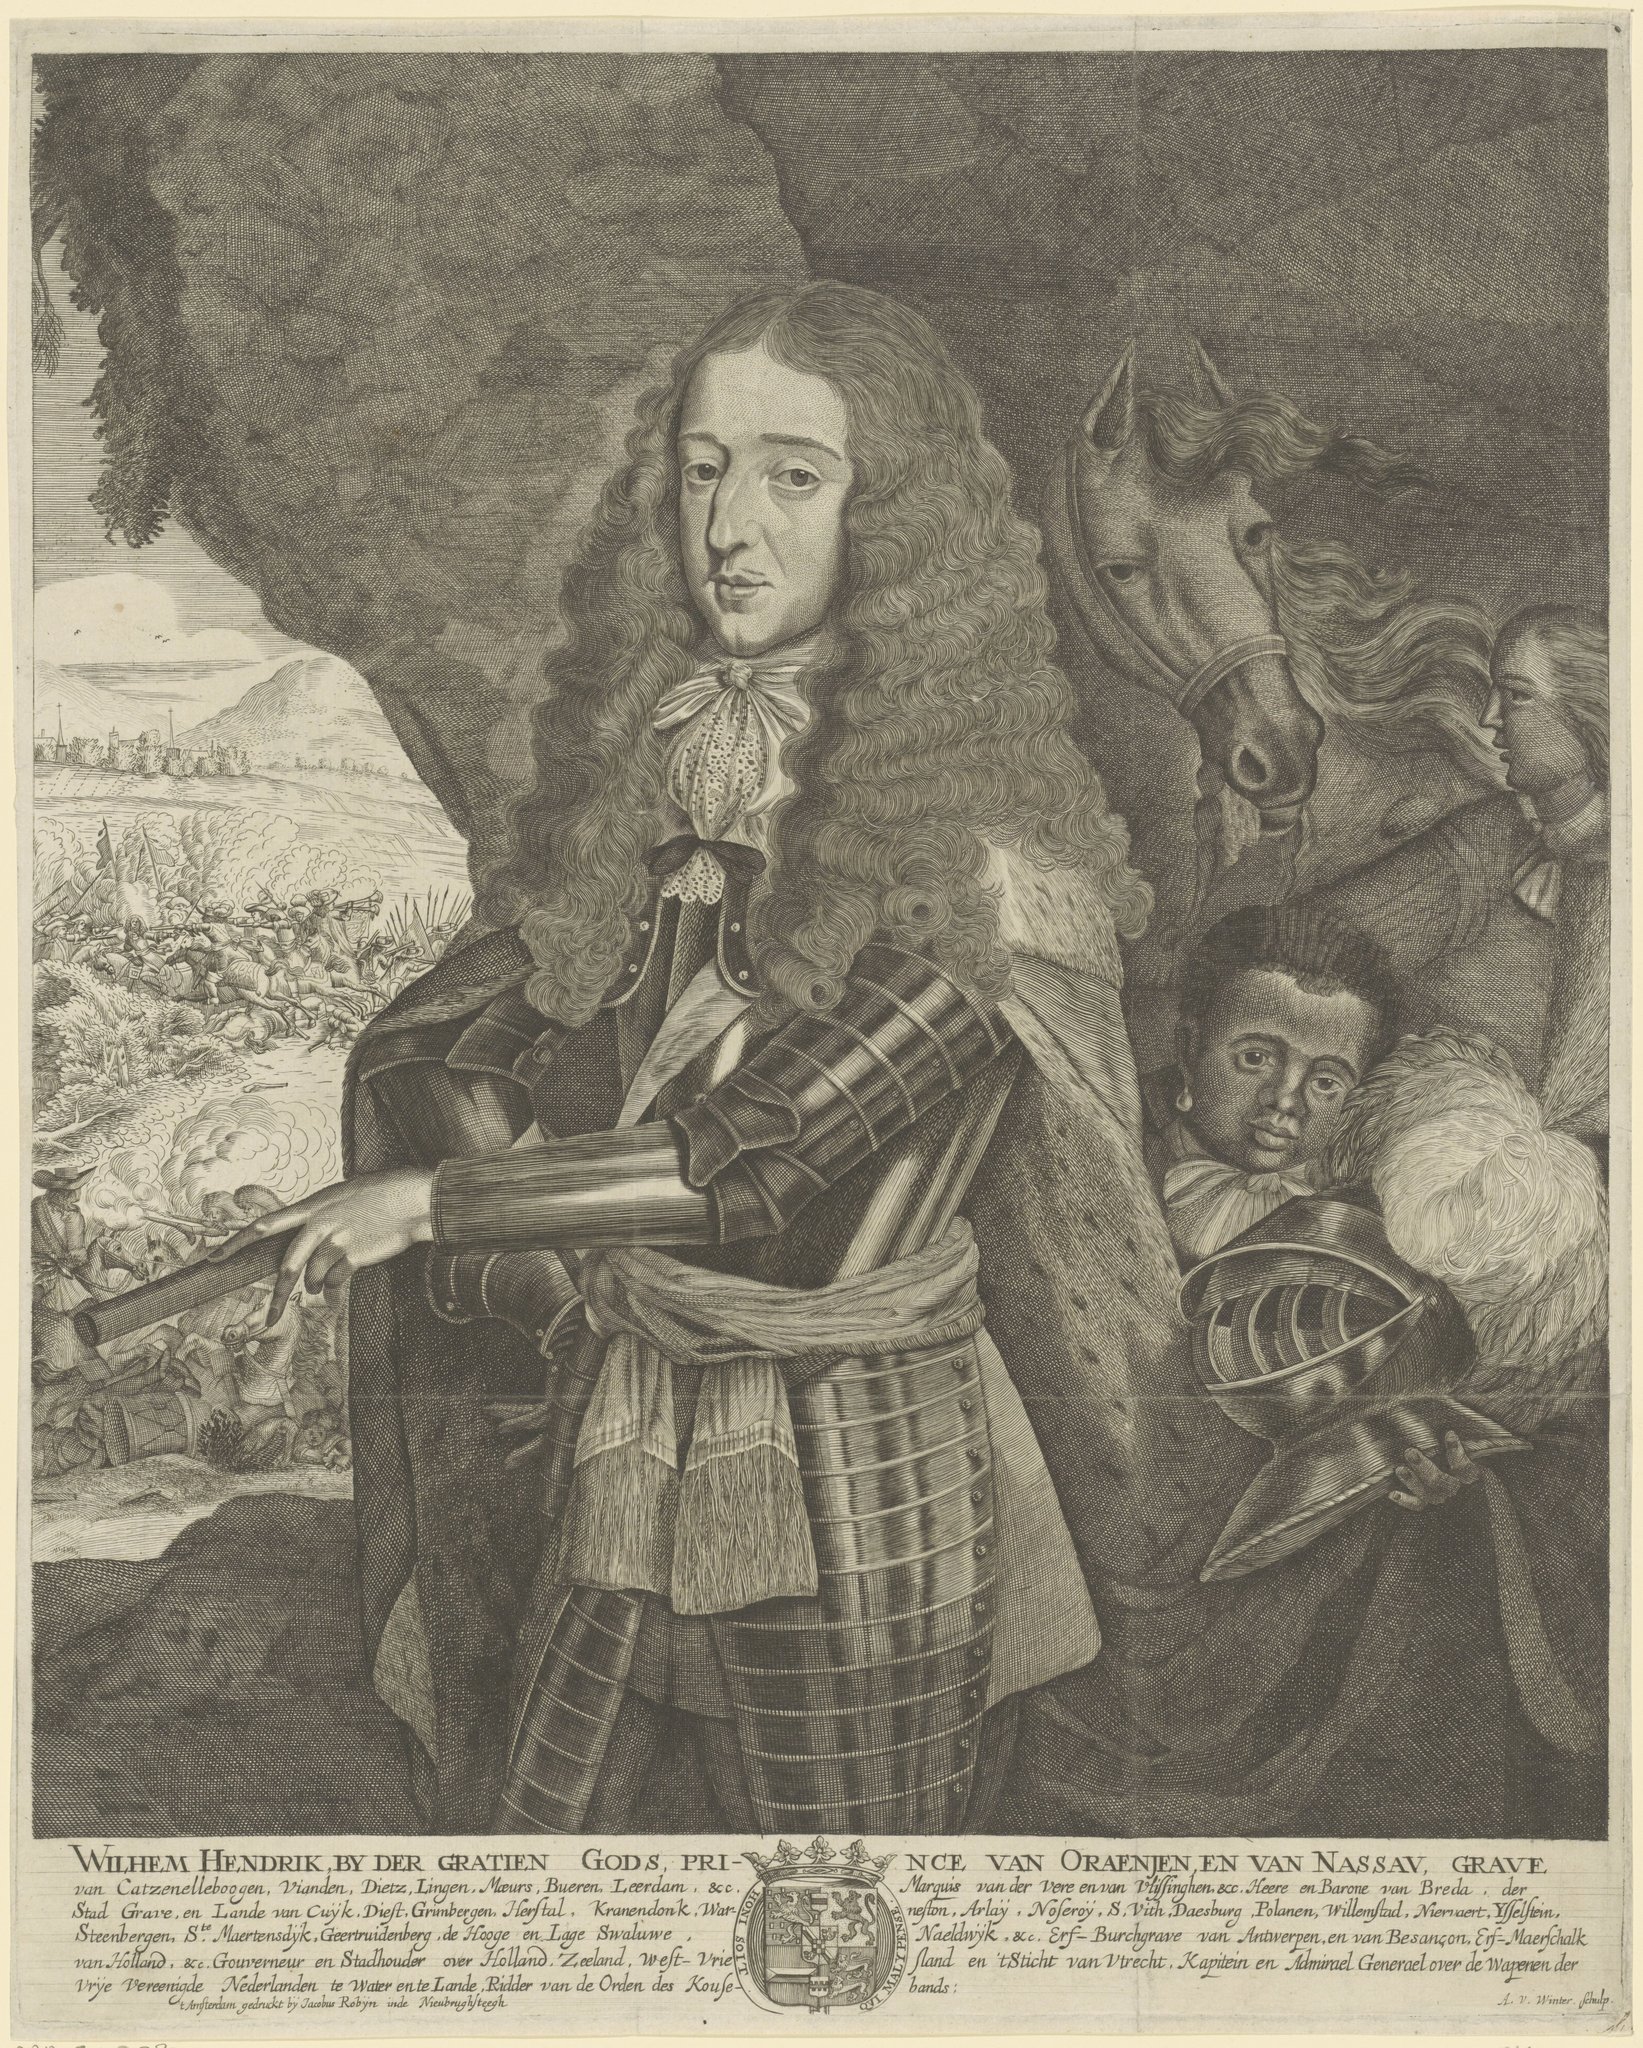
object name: print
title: Portret van Willem III, prins van Oranje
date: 1673-1707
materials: paper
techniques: engraving, etching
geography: amsterdam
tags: the hague, william iii (prince of orange and king of england, scotland, and ireland), knighthood order (garter) - insignia of a knighthood order, e.g.: badge, chain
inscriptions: collector's mark: Lugt 1098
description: Portret van Willem III. In zijn linkerhand een commandostaf. Rechts een donkere jongen met zijn helm en een man met een paard. Op de achtergrond een ruitergevecht. Midden onder zijn wapen met een kroon, gedecoreerd met de Kousenband en het devies van de Orde van de Kousenband. In de ondermarge zijn naam en titels.